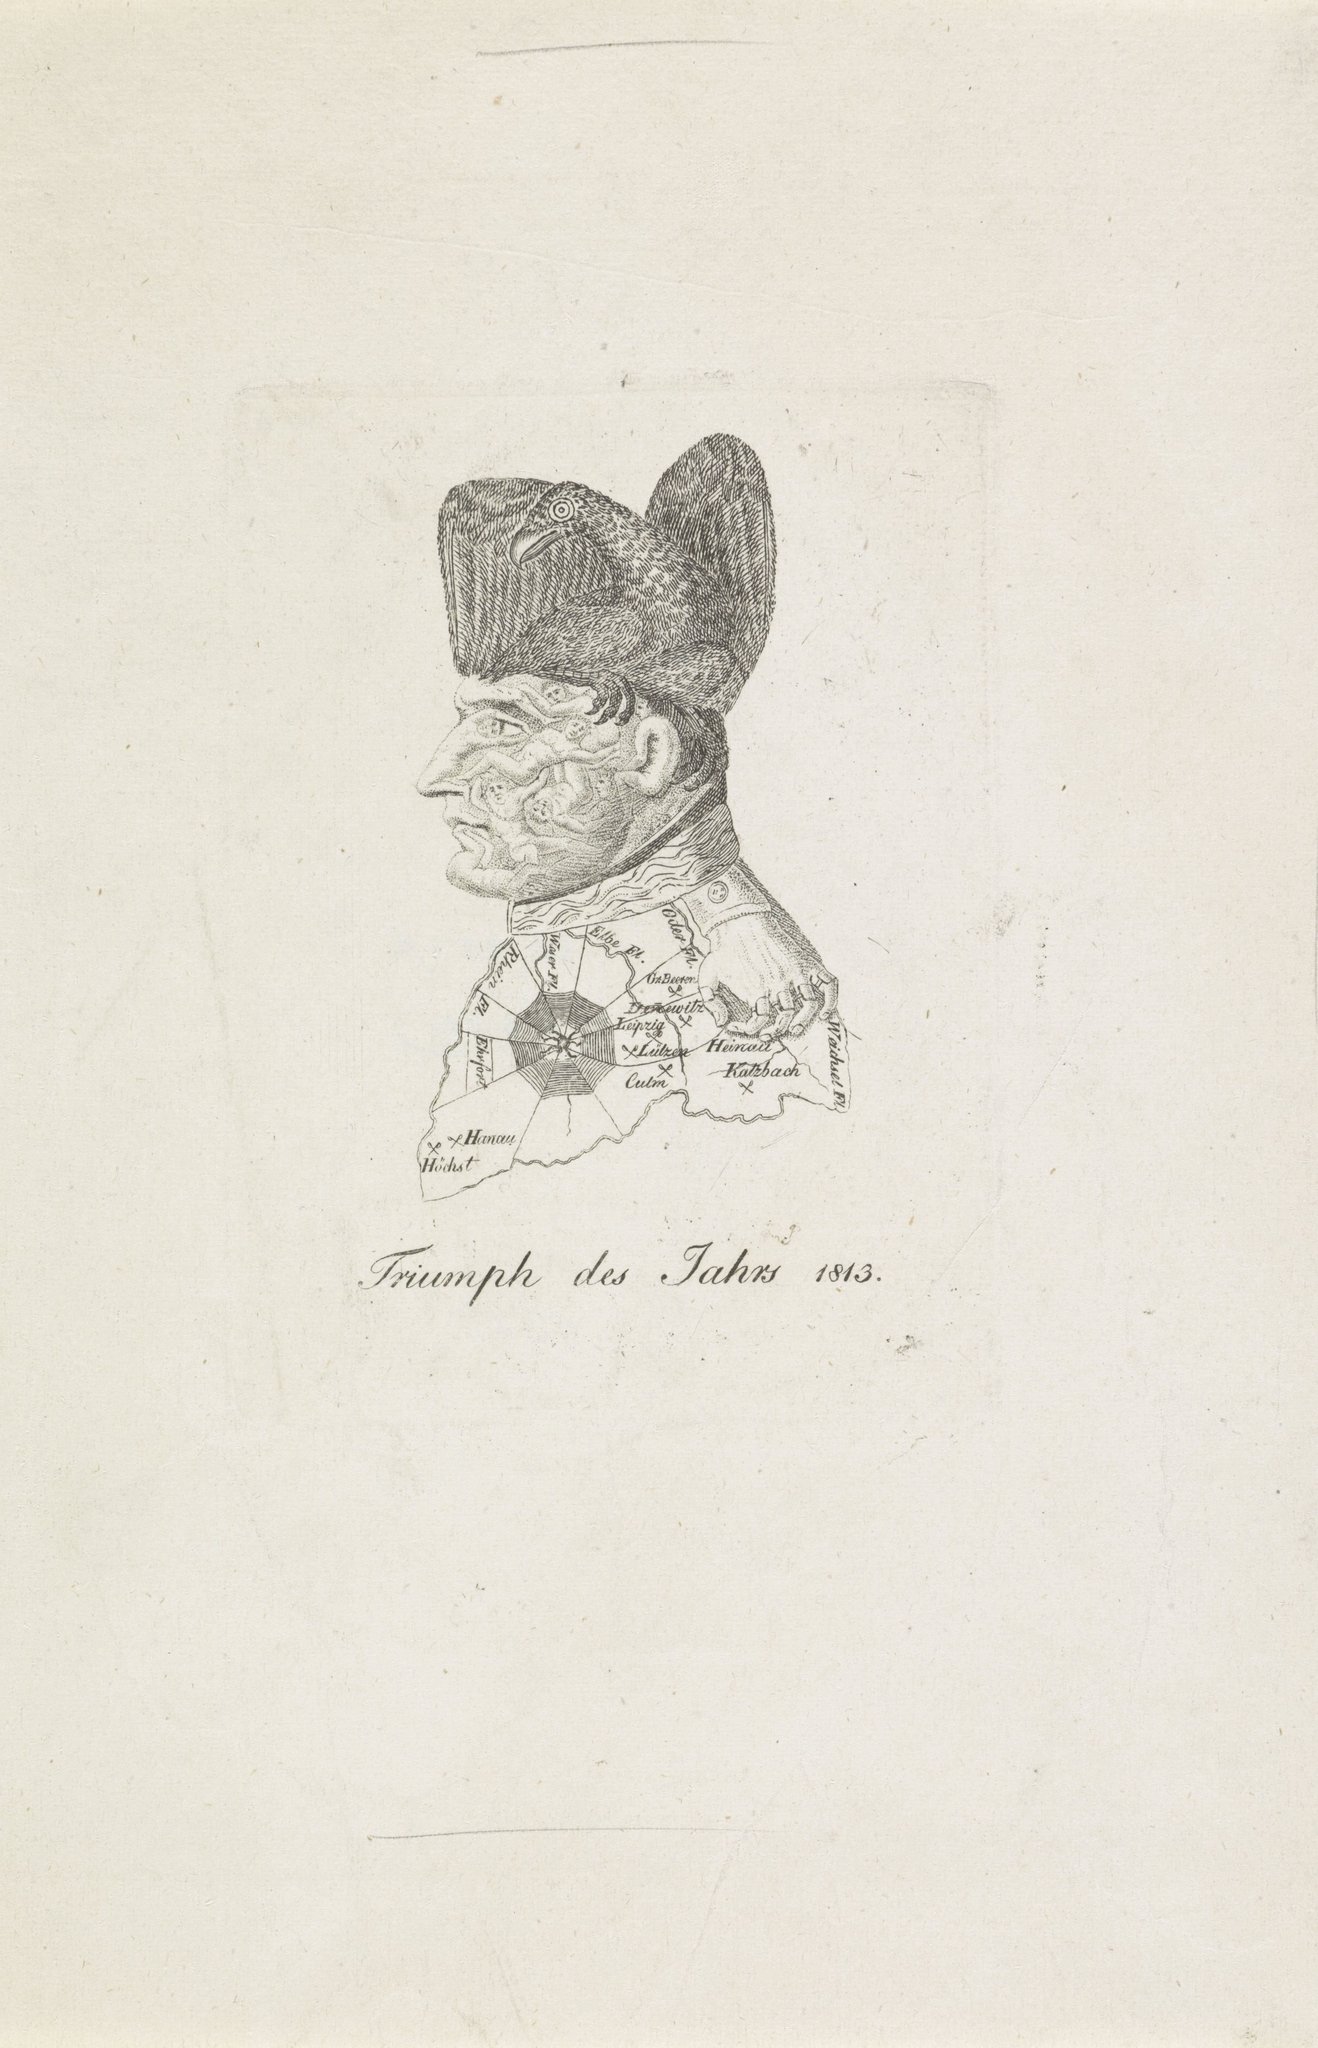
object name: cartoon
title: Spotprent op Napoleon, 1813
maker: Anonymous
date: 1813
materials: paper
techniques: engraving, etching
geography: germany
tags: napoleon i (emperor of the french), political caricatures and satires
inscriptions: collector's mark: Lugt 2228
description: Spotprent op Napoleon van 1813 waarbij zijn gezicht is opgebouwd uit de lijken van zijn slachtoffers, zijn hoed is de Pruisische adelaar, zijn epaulet is een grijpende hand. De kraag is een rivier van bloed, zijn jas het slagveld van Europa en het ordeteken van het Legioen van Eer op zijn borst is een spinnenweb.